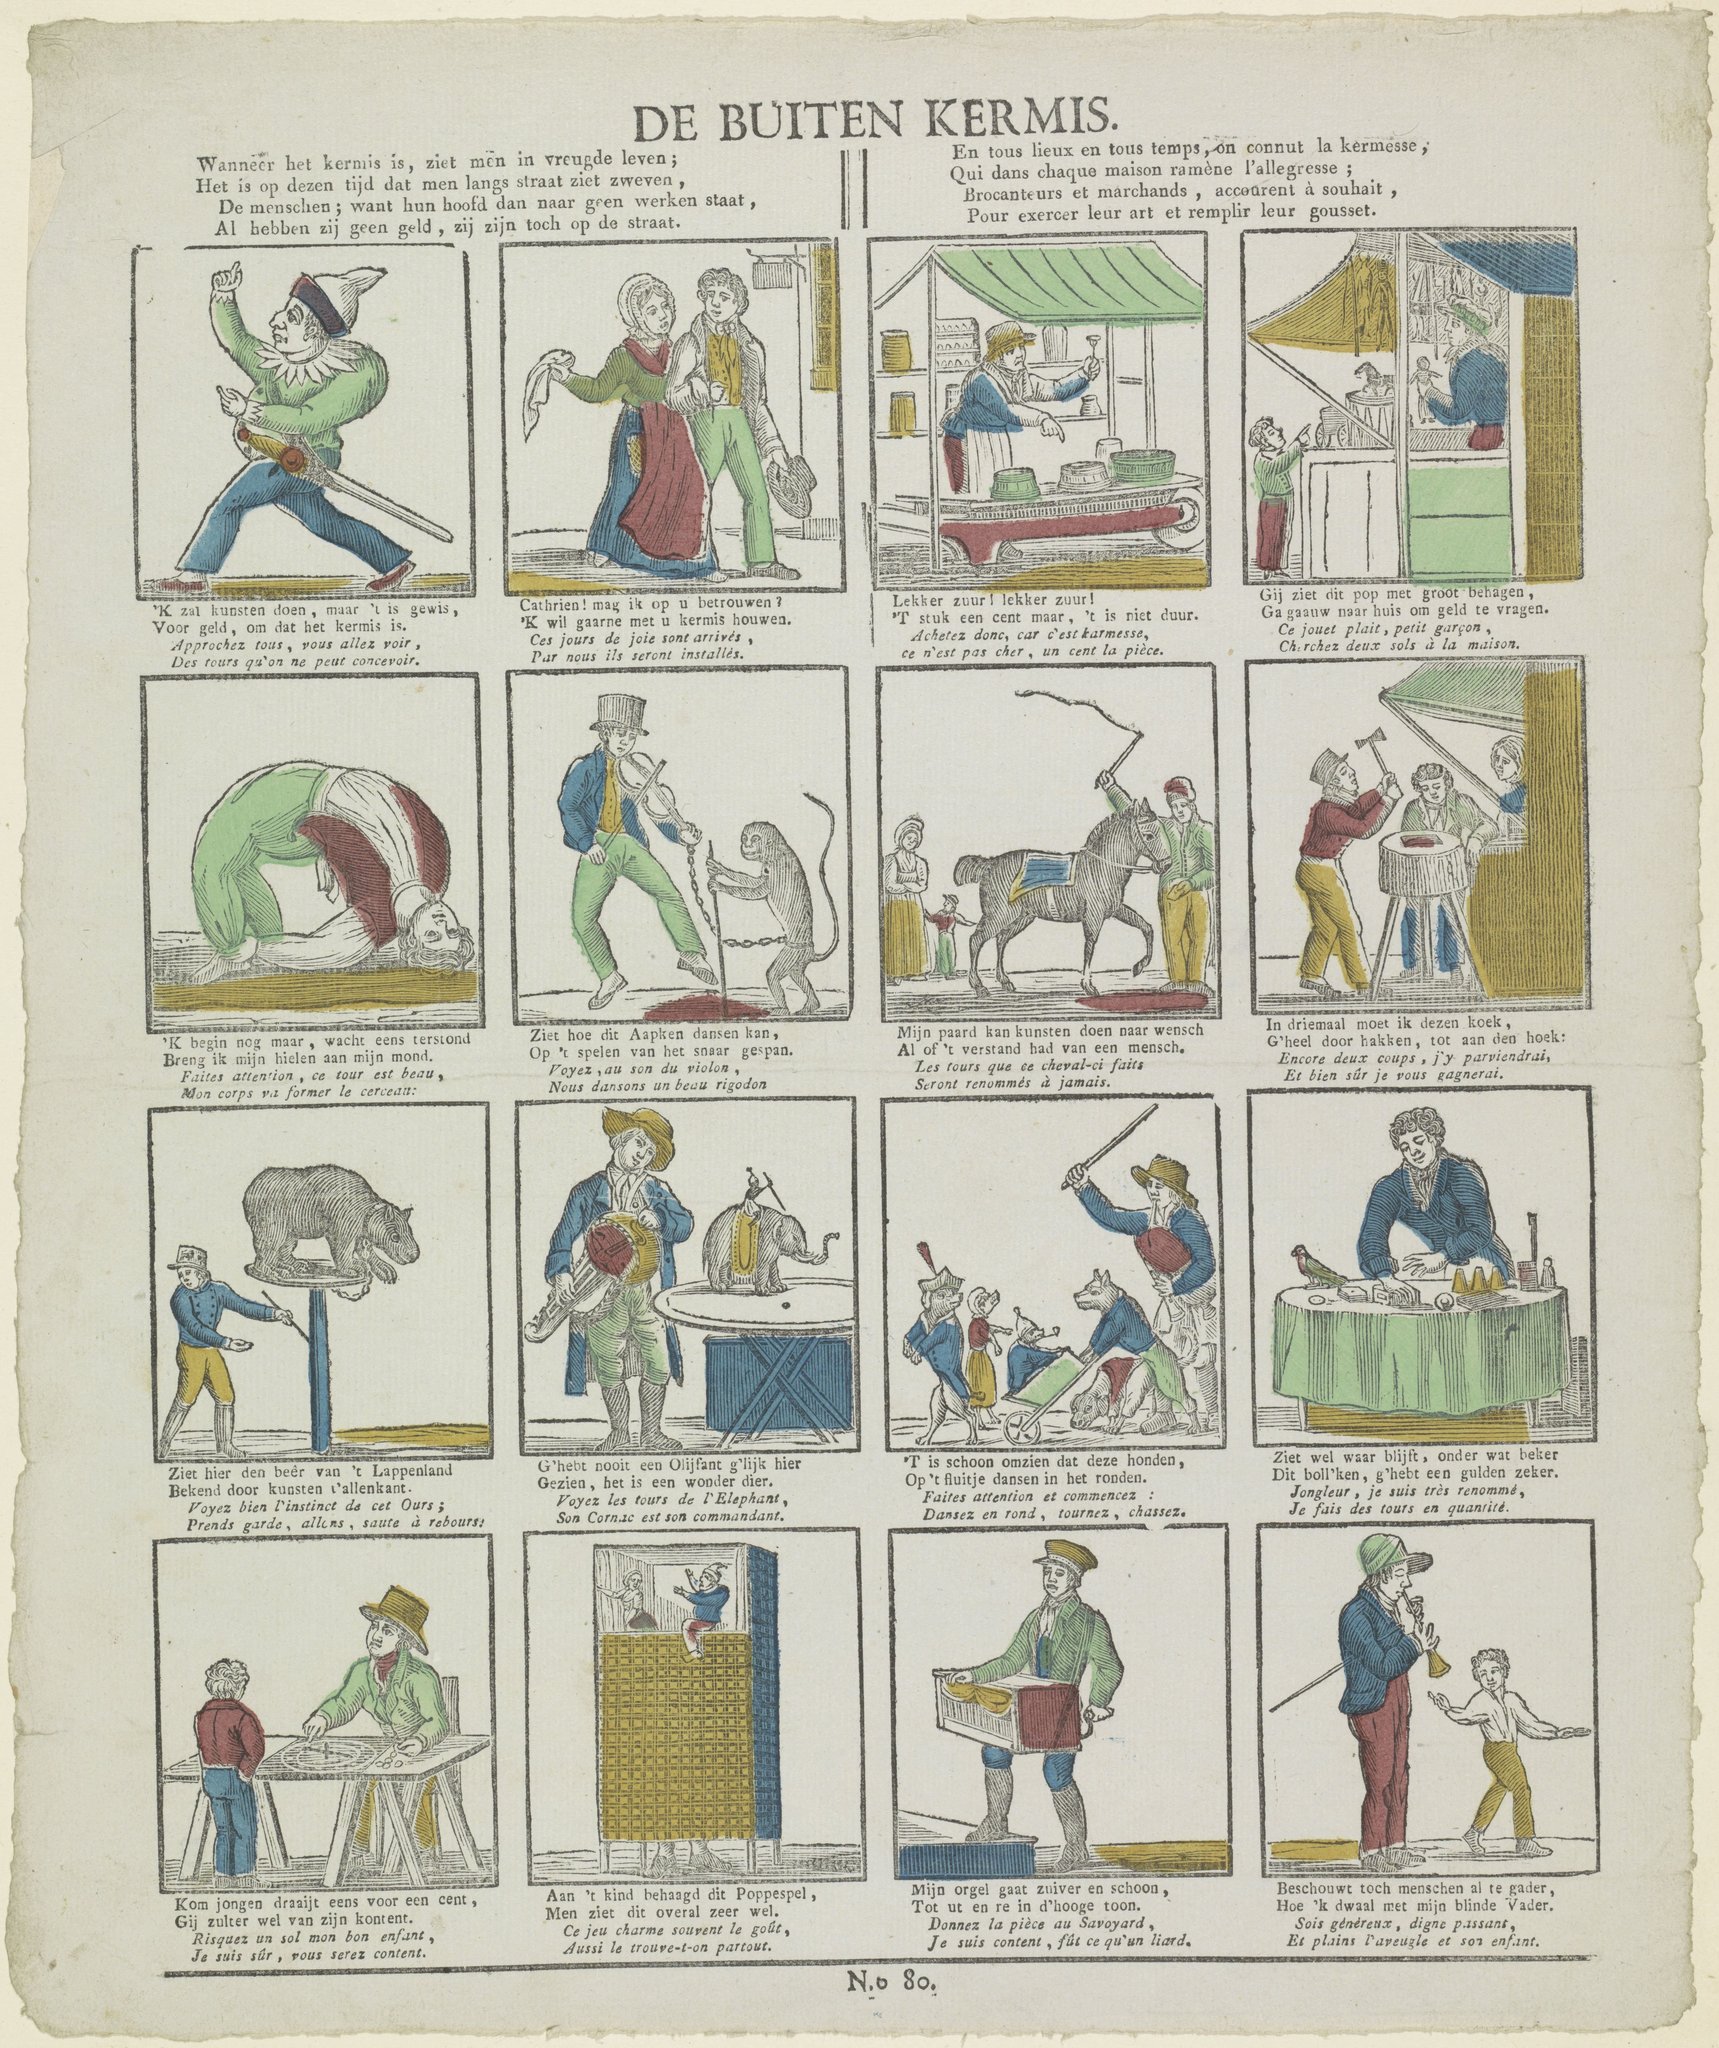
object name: print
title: De buitenkermis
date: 1800-1833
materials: paper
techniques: colour, letterpress printing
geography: turnhout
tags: bears (circus performance), circus animals, circus performance with trained animals (monkeys, elephants, bears, lions and tigers, horses, dogs, dolphins, seals, fleas), acrobat ~ circus, pleasure fair and circus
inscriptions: collector's mark: Lugt 2760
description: Blad met 16 kermistaferelen, waaronder voorstellingen van een dansende aap, een lenige man en honden die kunstjes kunnen. Onder elke afbeelding een tweeregelig vers in het Nederlands en in het Frans, boven een vierregelig vers in het Nederlands en in het Frans in twee kolommen. Genummerd midden onder: No. 80.